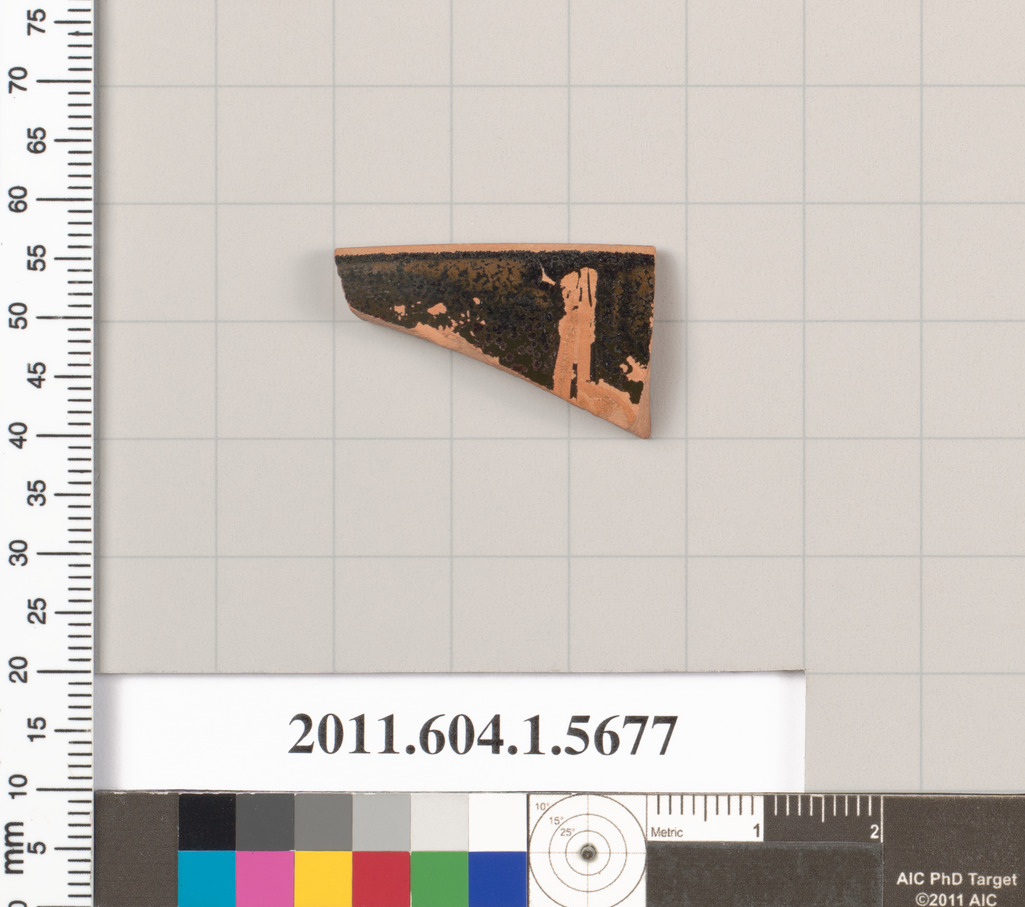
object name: kylix fragment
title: Terracotta rim fragment of a kylix (drinking cup)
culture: greek, attic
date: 500-480 BCE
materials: terracotta